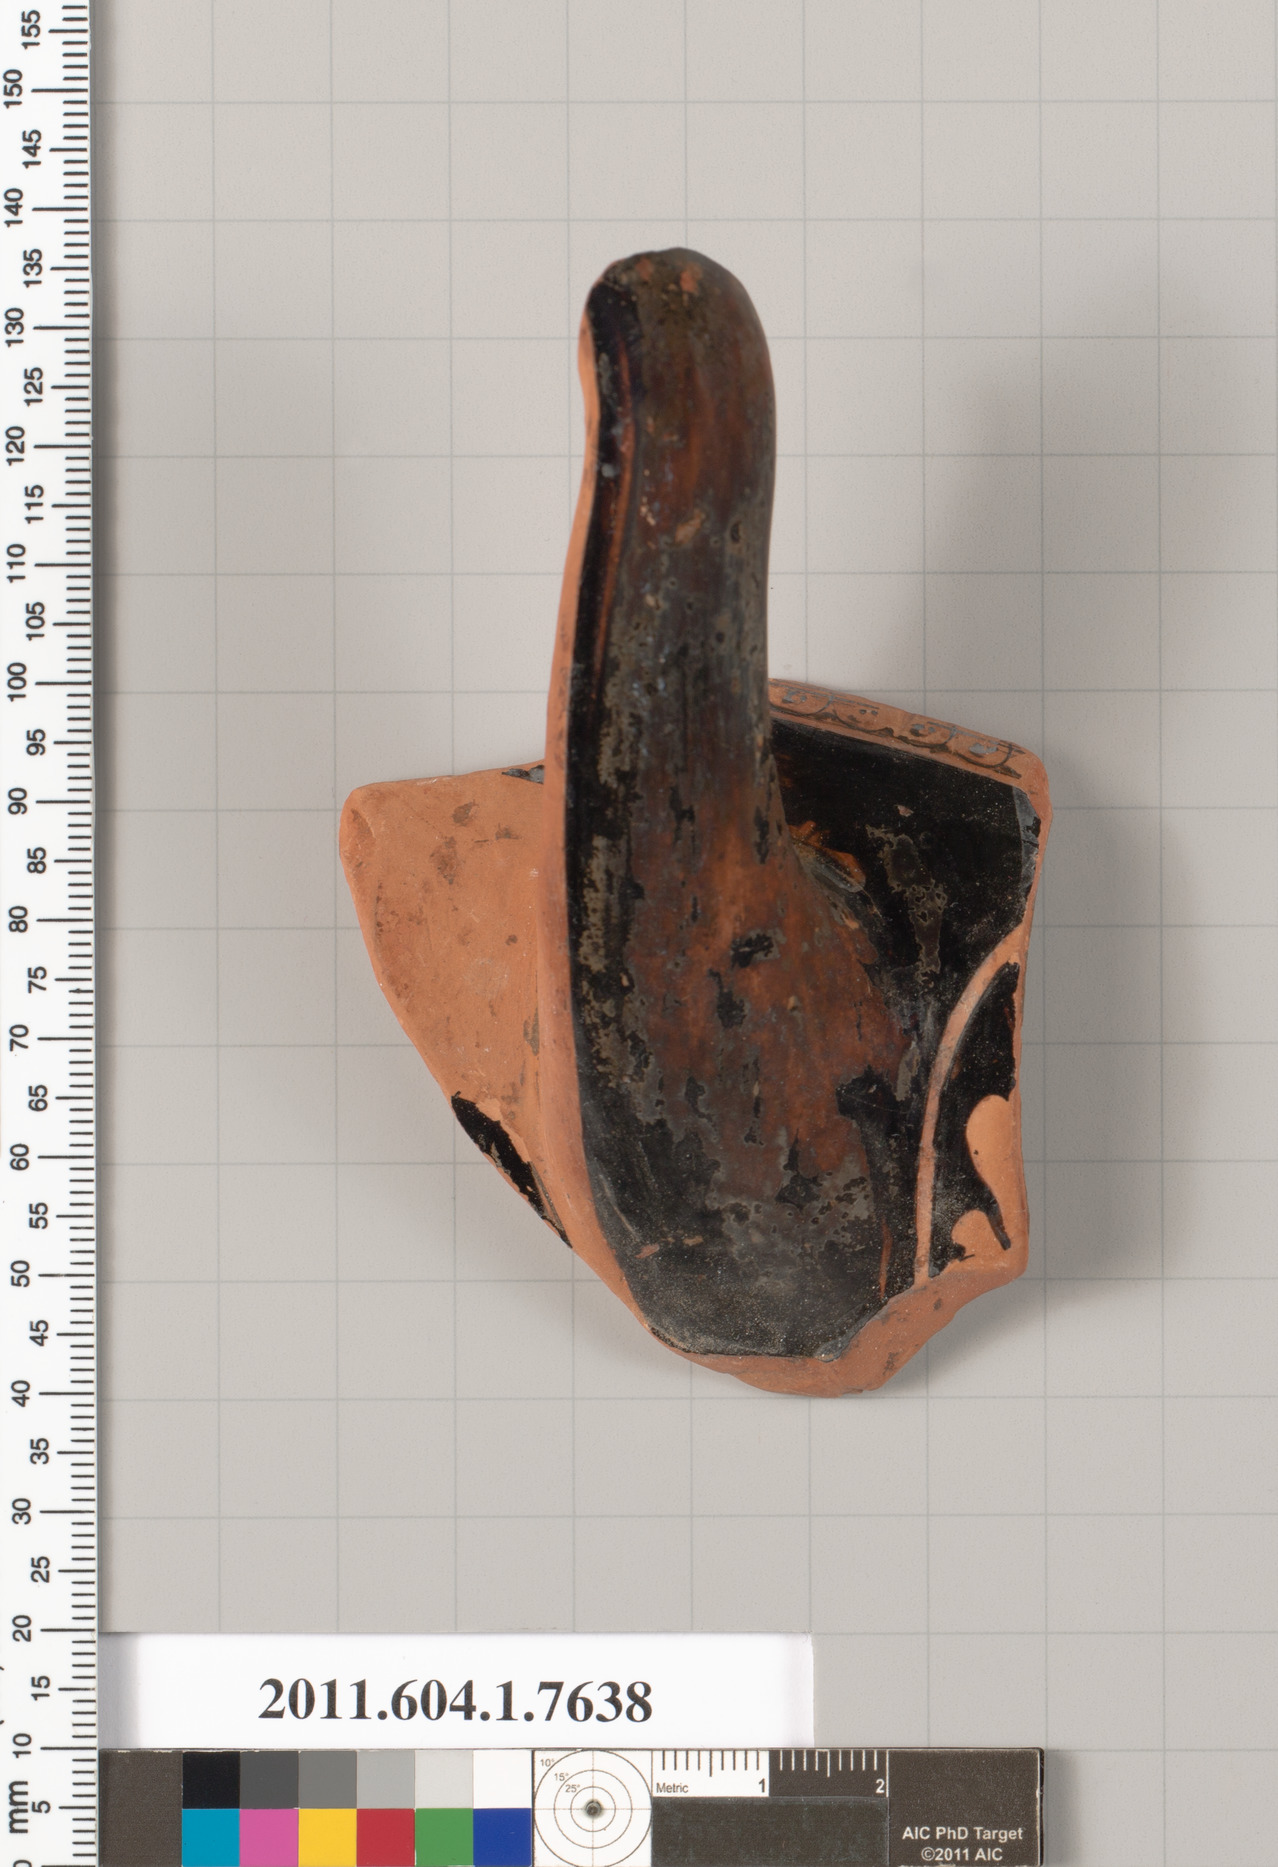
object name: kylix fragment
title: Terracotta fragment of a kylix (drinking cup)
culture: greek, attic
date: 460-450 BCE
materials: terracotta